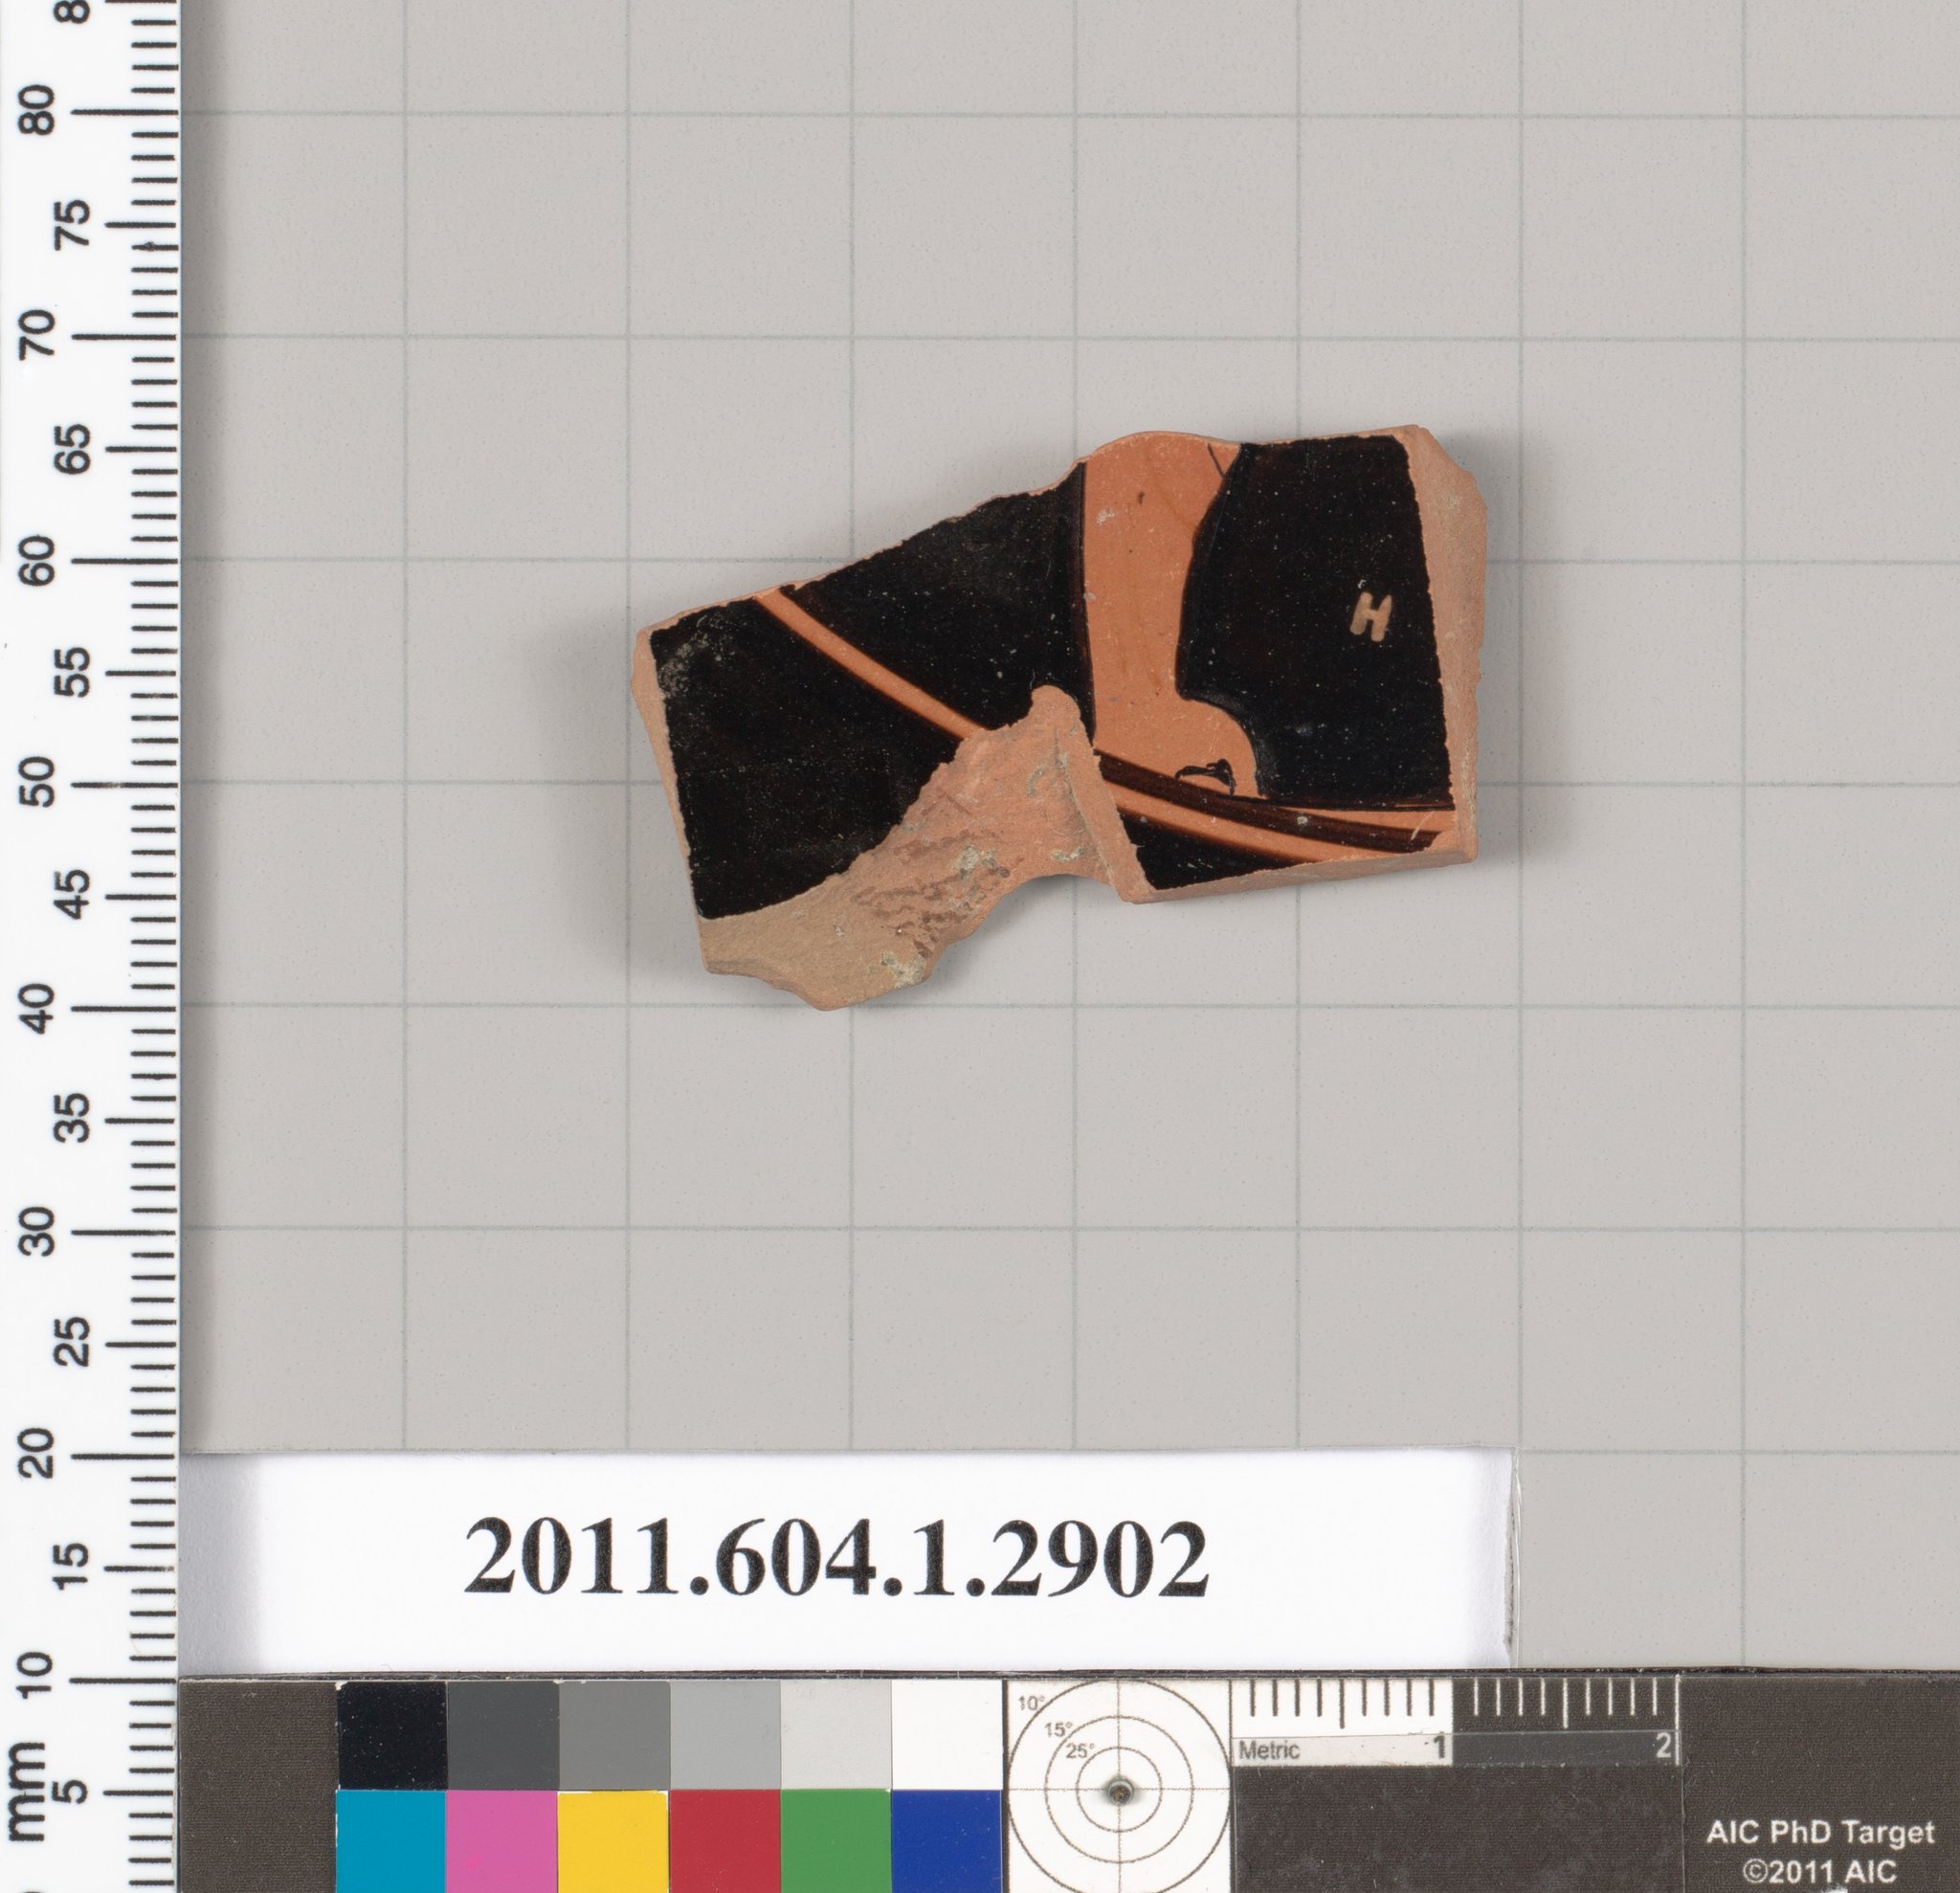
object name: kylix fragment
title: Terracotta fragment of a kylix (drinking cup)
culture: greek, attic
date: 520-490 BCE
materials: terracotta